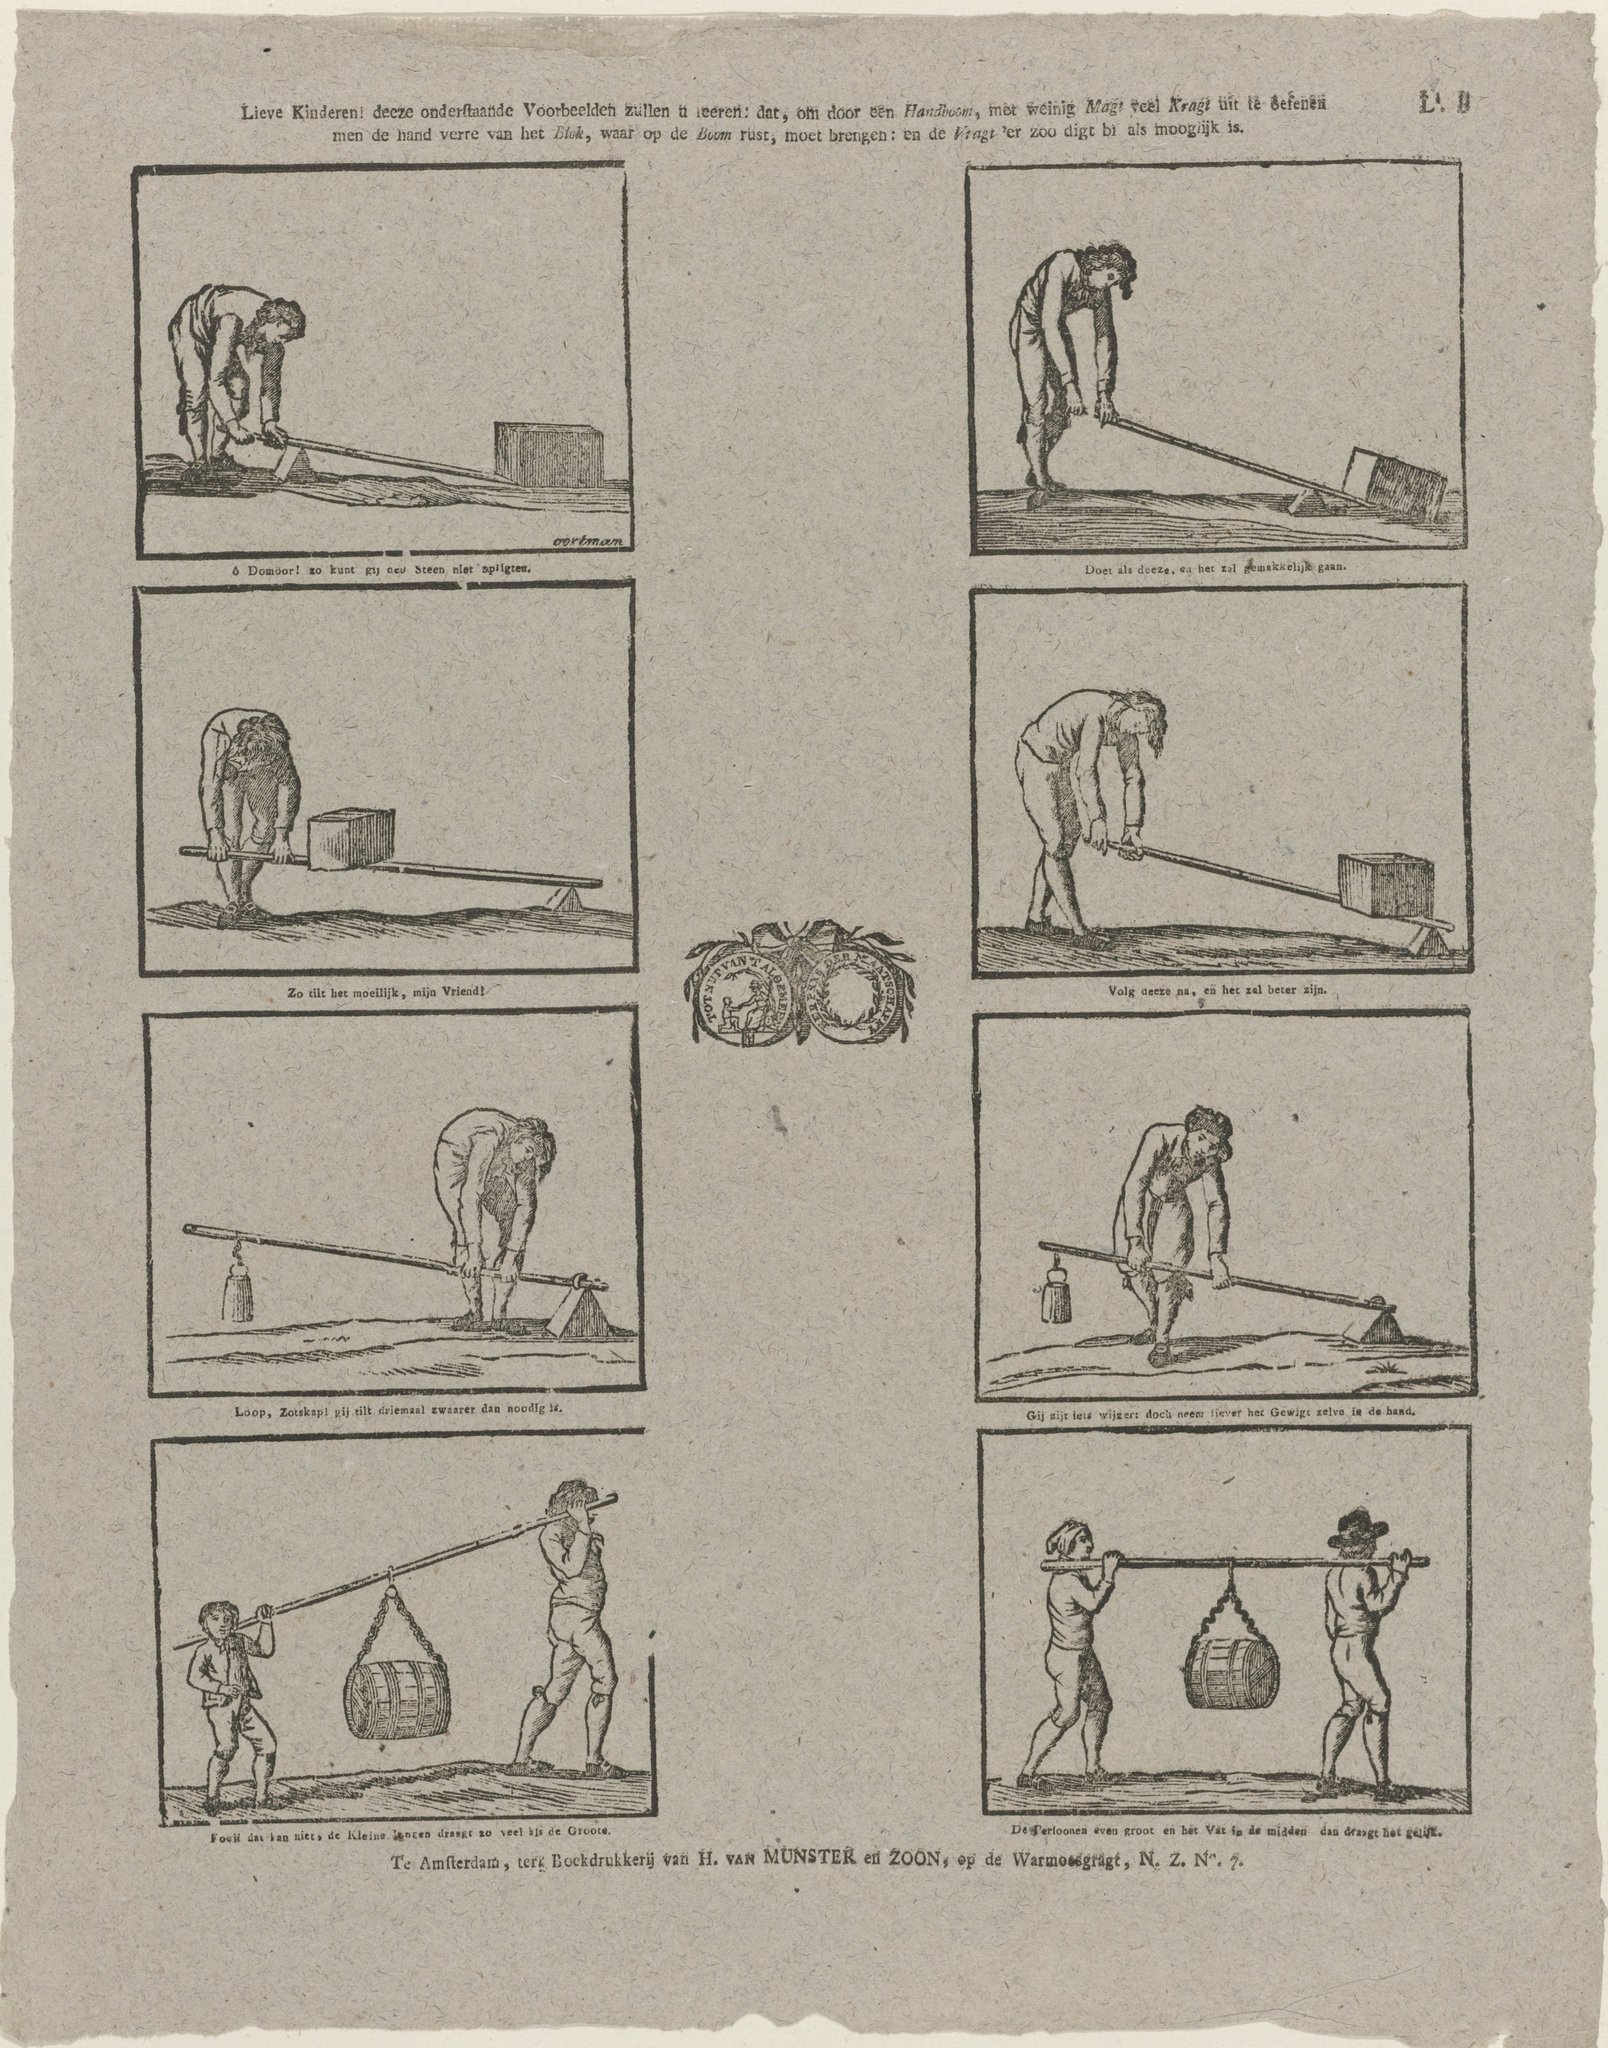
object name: print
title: Lieve kinderen! deeze onderstaande voorbeelden zullen u leeren: dat, om door een handboom, met weinig magt veel kragt uit te oefenen [(...)]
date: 1811-1829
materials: paper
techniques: letterpress printing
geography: amsterdam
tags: dynamics, kinetics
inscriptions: collector's mark: Lugt 2760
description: Blad met 8 voorstellingen van de werking van dynamica en de hefboom. In het midden het zegel van de Maatschappij tot Nut van 't Algemeen. Onder elke afbeelding een onderschrift. Genummerd rechtsboven: L.B.